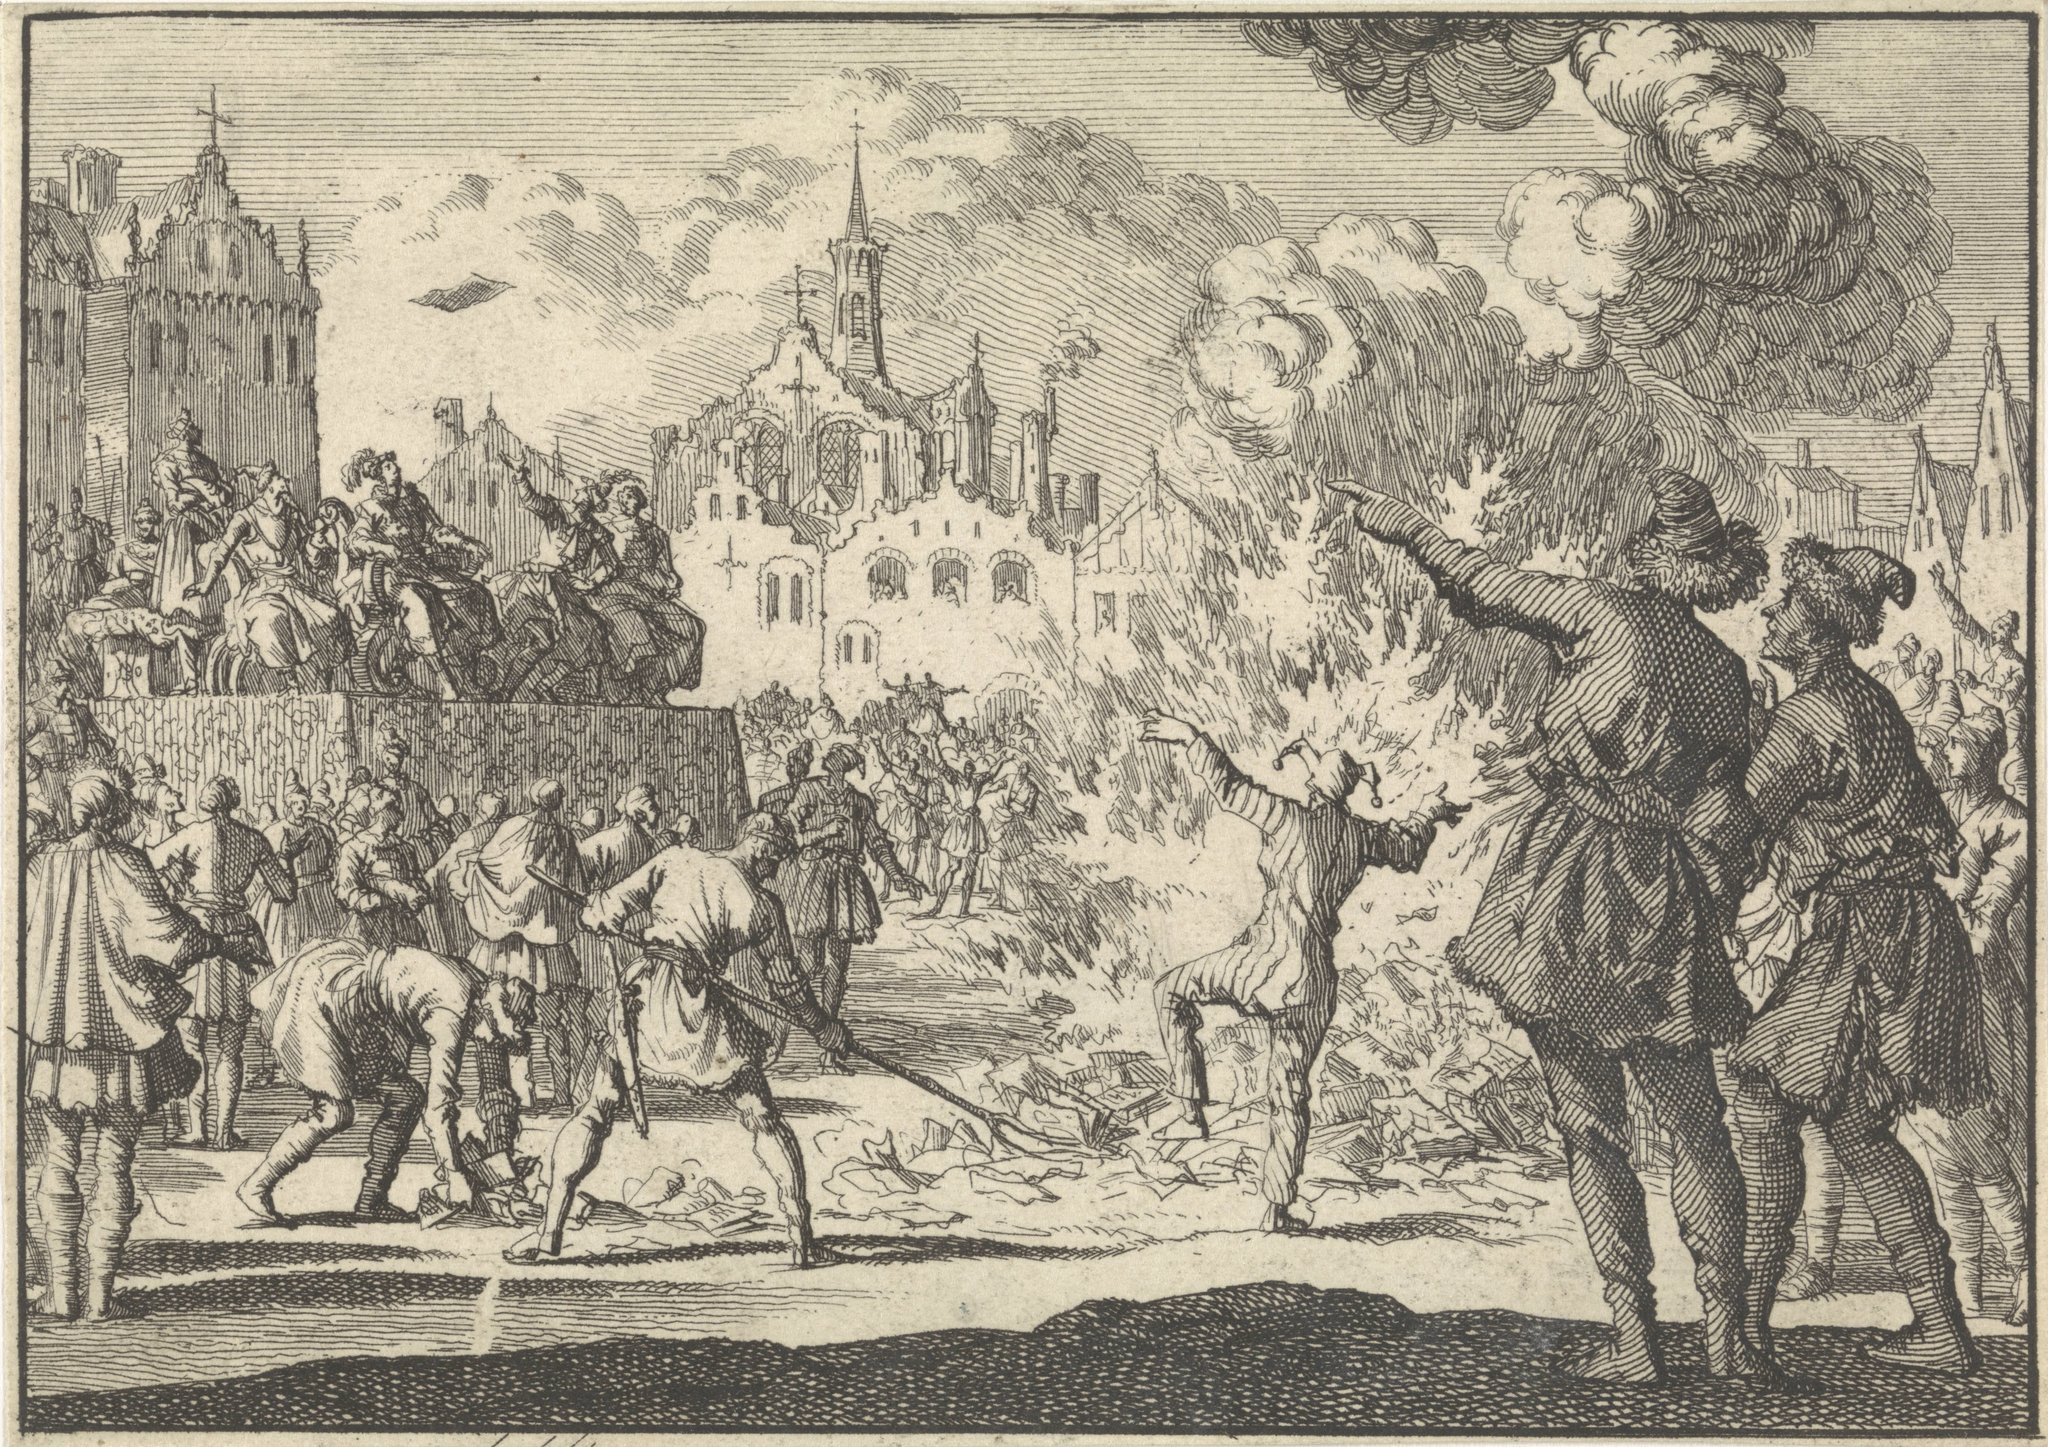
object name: book illustration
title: Bijbelverbranding in Hongarije, ca. 1660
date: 1698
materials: paper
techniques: etching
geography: amsterdam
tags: the bible as a book, burning of books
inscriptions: collector's mark: Lugt 2228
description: Illustratie uit: Gottfried, Johann Ludwig. Historische kronyck; vervattende een (...) beschrijvingh der aldergedenckwaerdigste geschiedenissen des weerelds, van den aenvangh der scheppingh tot (...) 1576 (2 delen). Leiden: Pieter van der Aa, 1698, dl. II, p. 639.